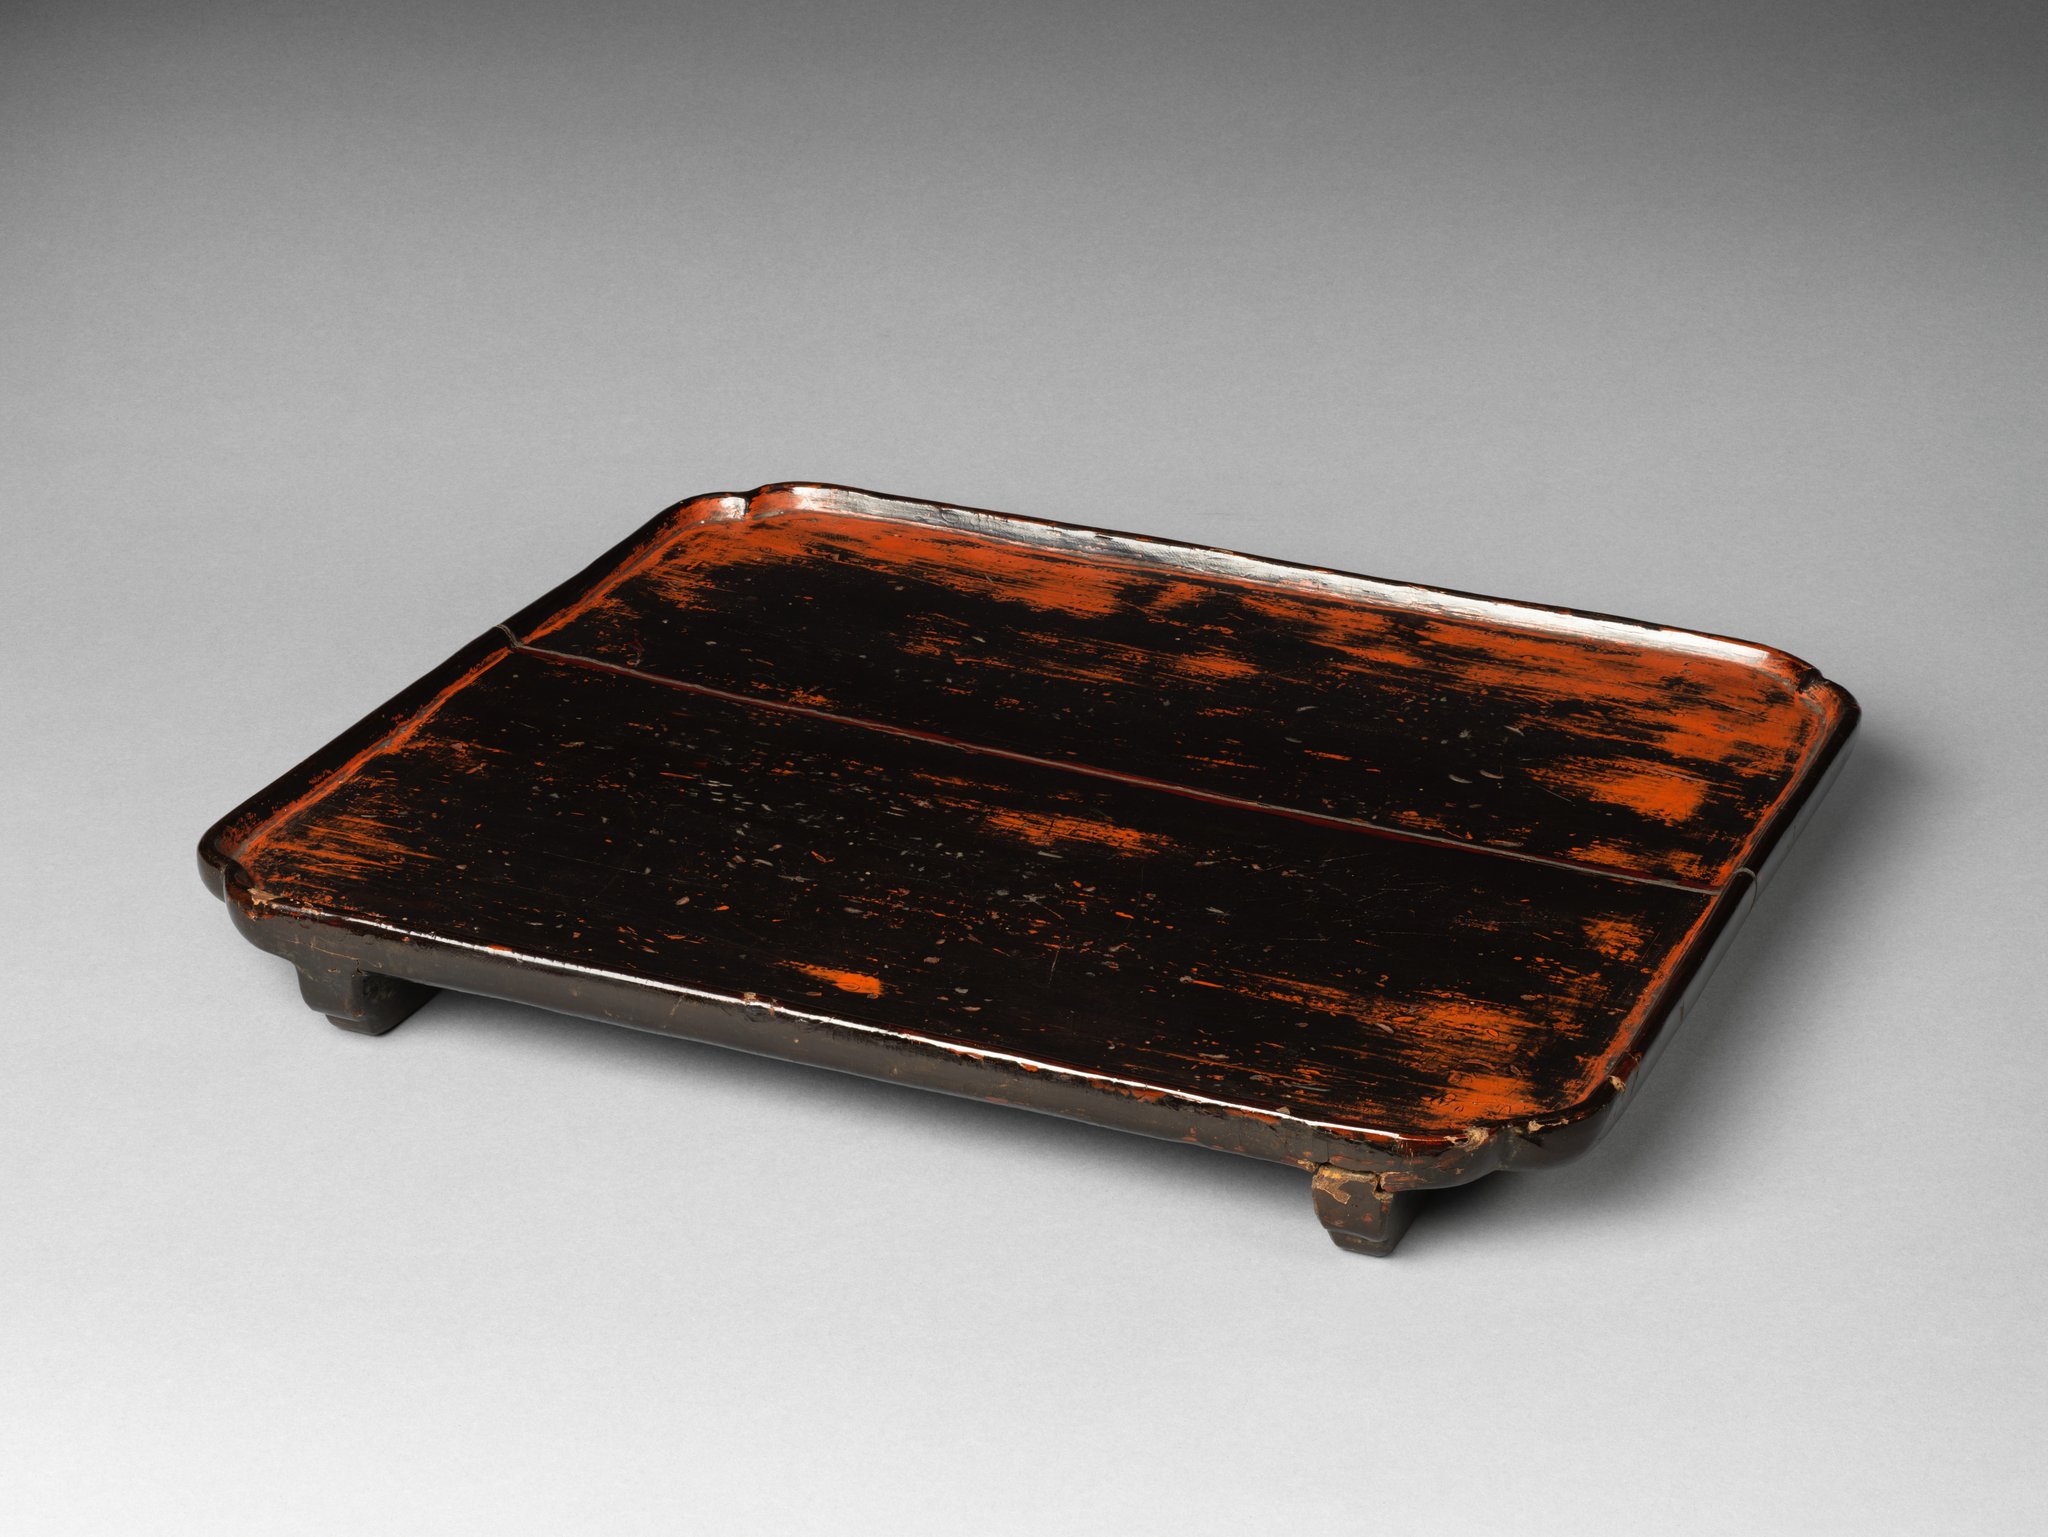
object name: tray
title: Angoya-type Negoro Tray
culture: japanese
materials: lacquer, wood